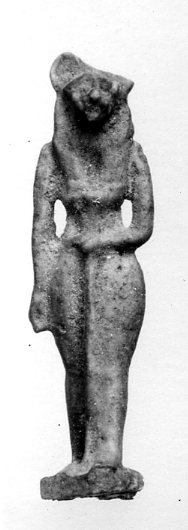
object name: amulet, sakhmet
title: Sakhmet Amulet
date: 664-630 BCE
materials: faience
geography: egypt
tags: sekhmet